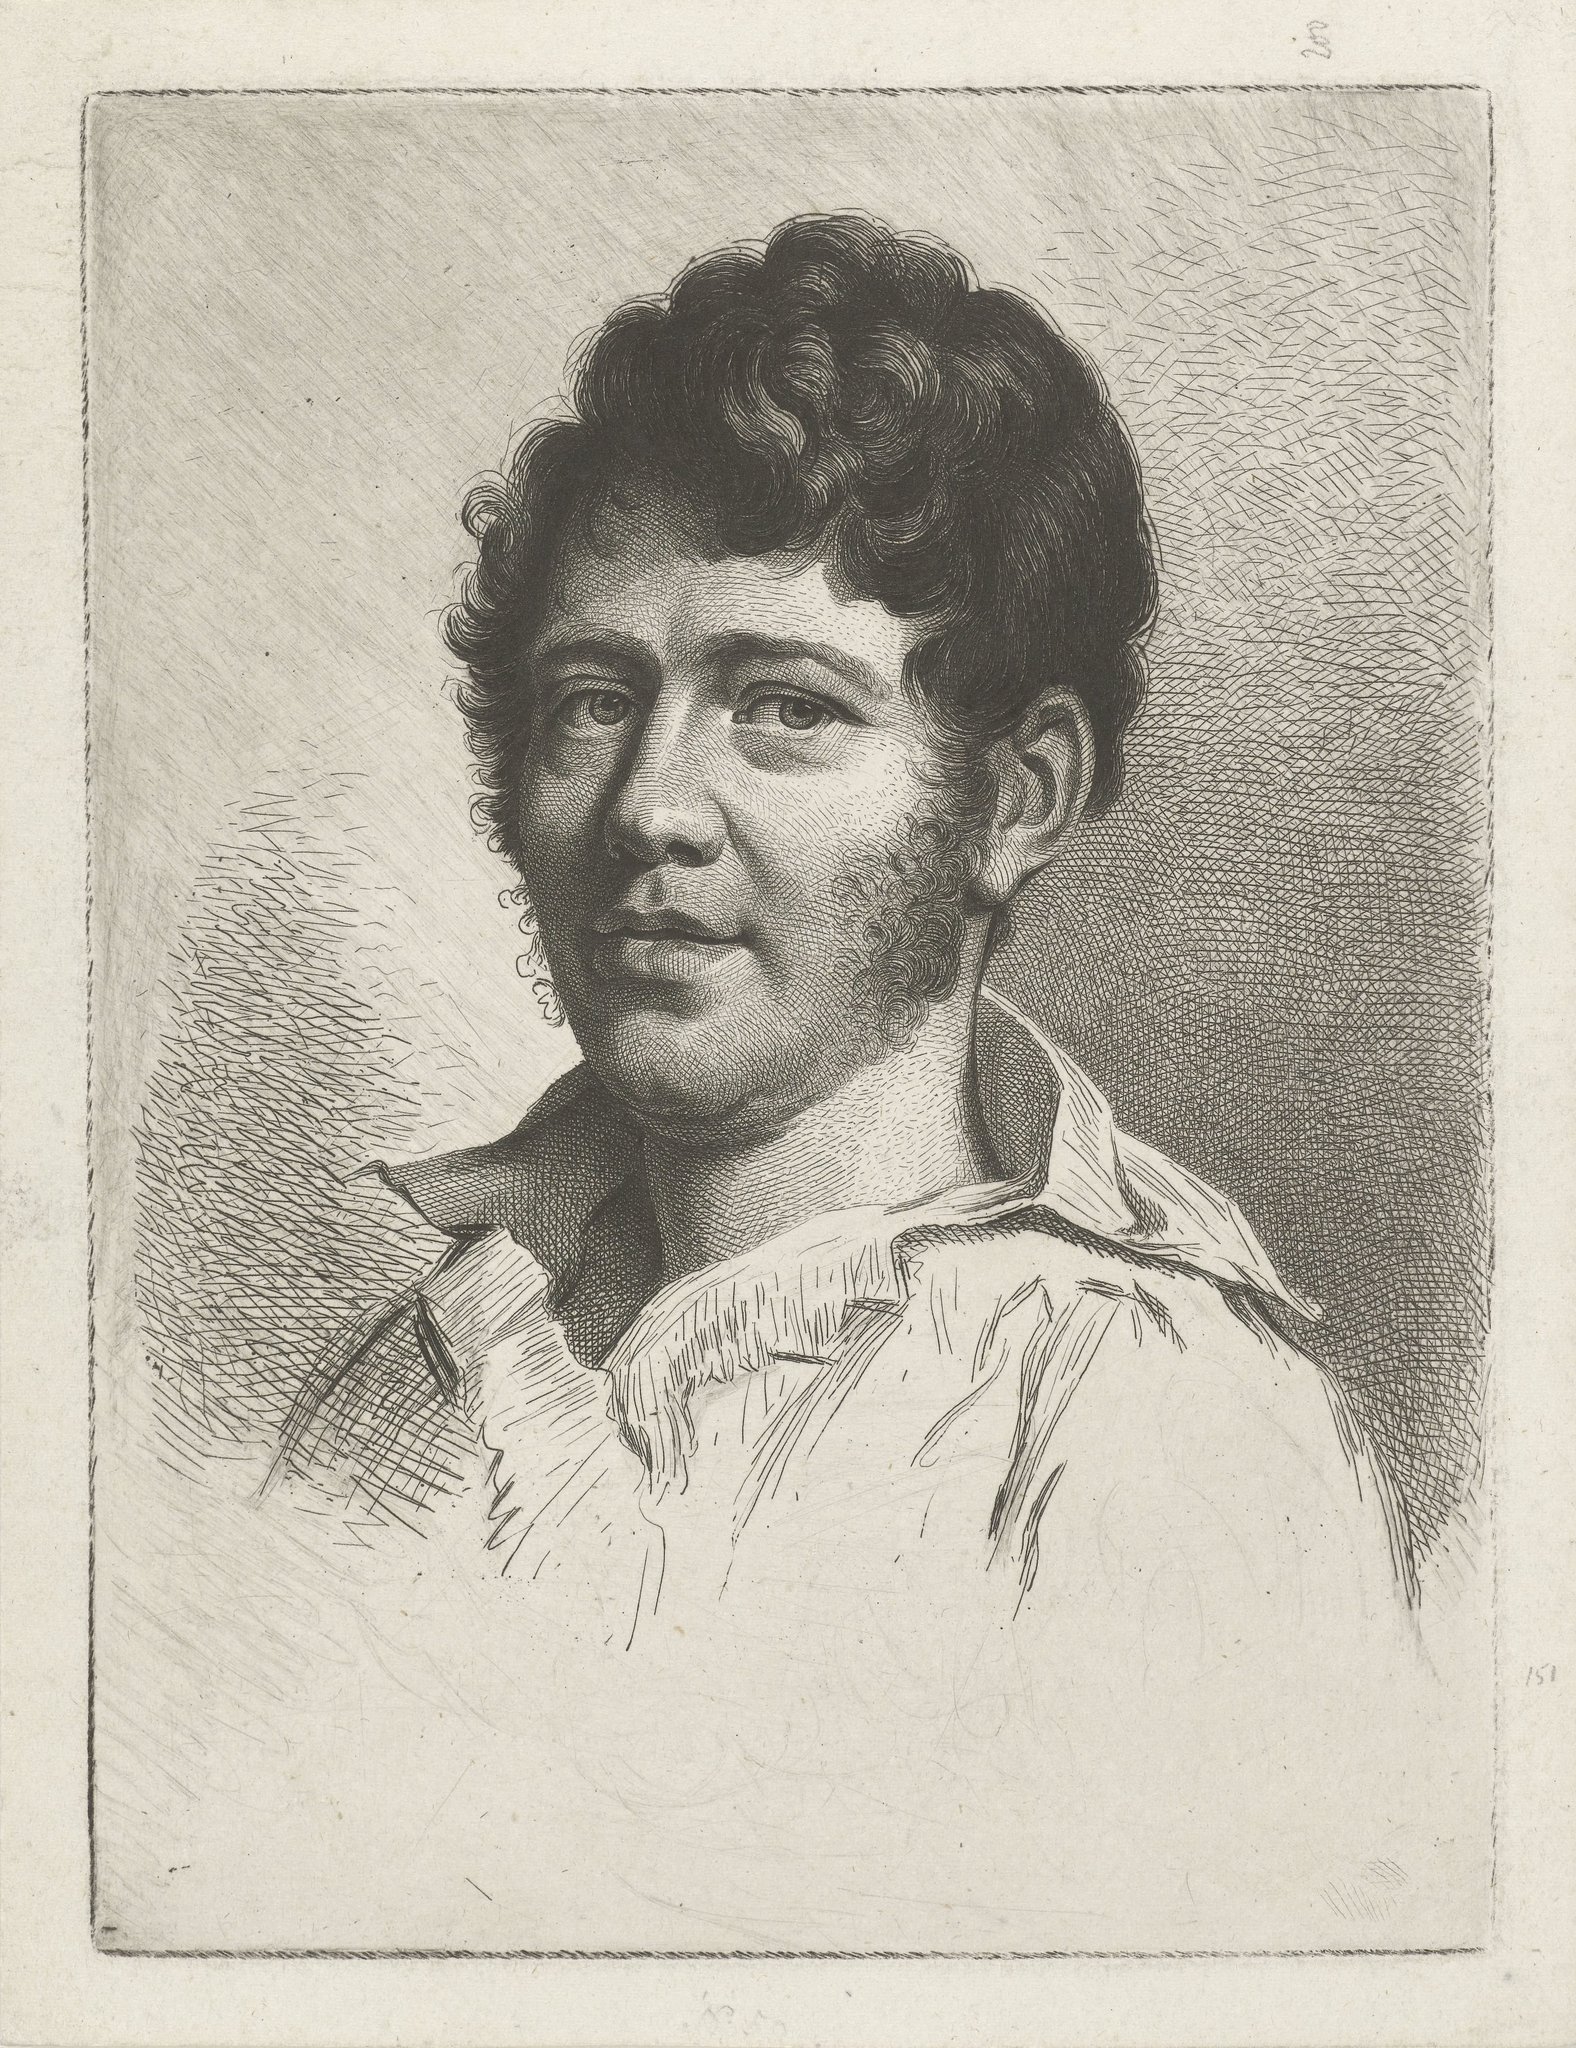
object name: print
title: Portret van een onbekende man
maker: johannes pieter de frey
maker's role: draughtsman, print maker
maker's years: 1770-1834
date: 1780-1834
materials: paper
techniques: etching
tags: anonymous historical person portrayed alone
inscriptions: collector's mark: Lugt 2228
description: Portret van een onbekende man waarbij alleen het hoofd en de nek in detail zijn uitgewerkt. Portretbuste naar links.